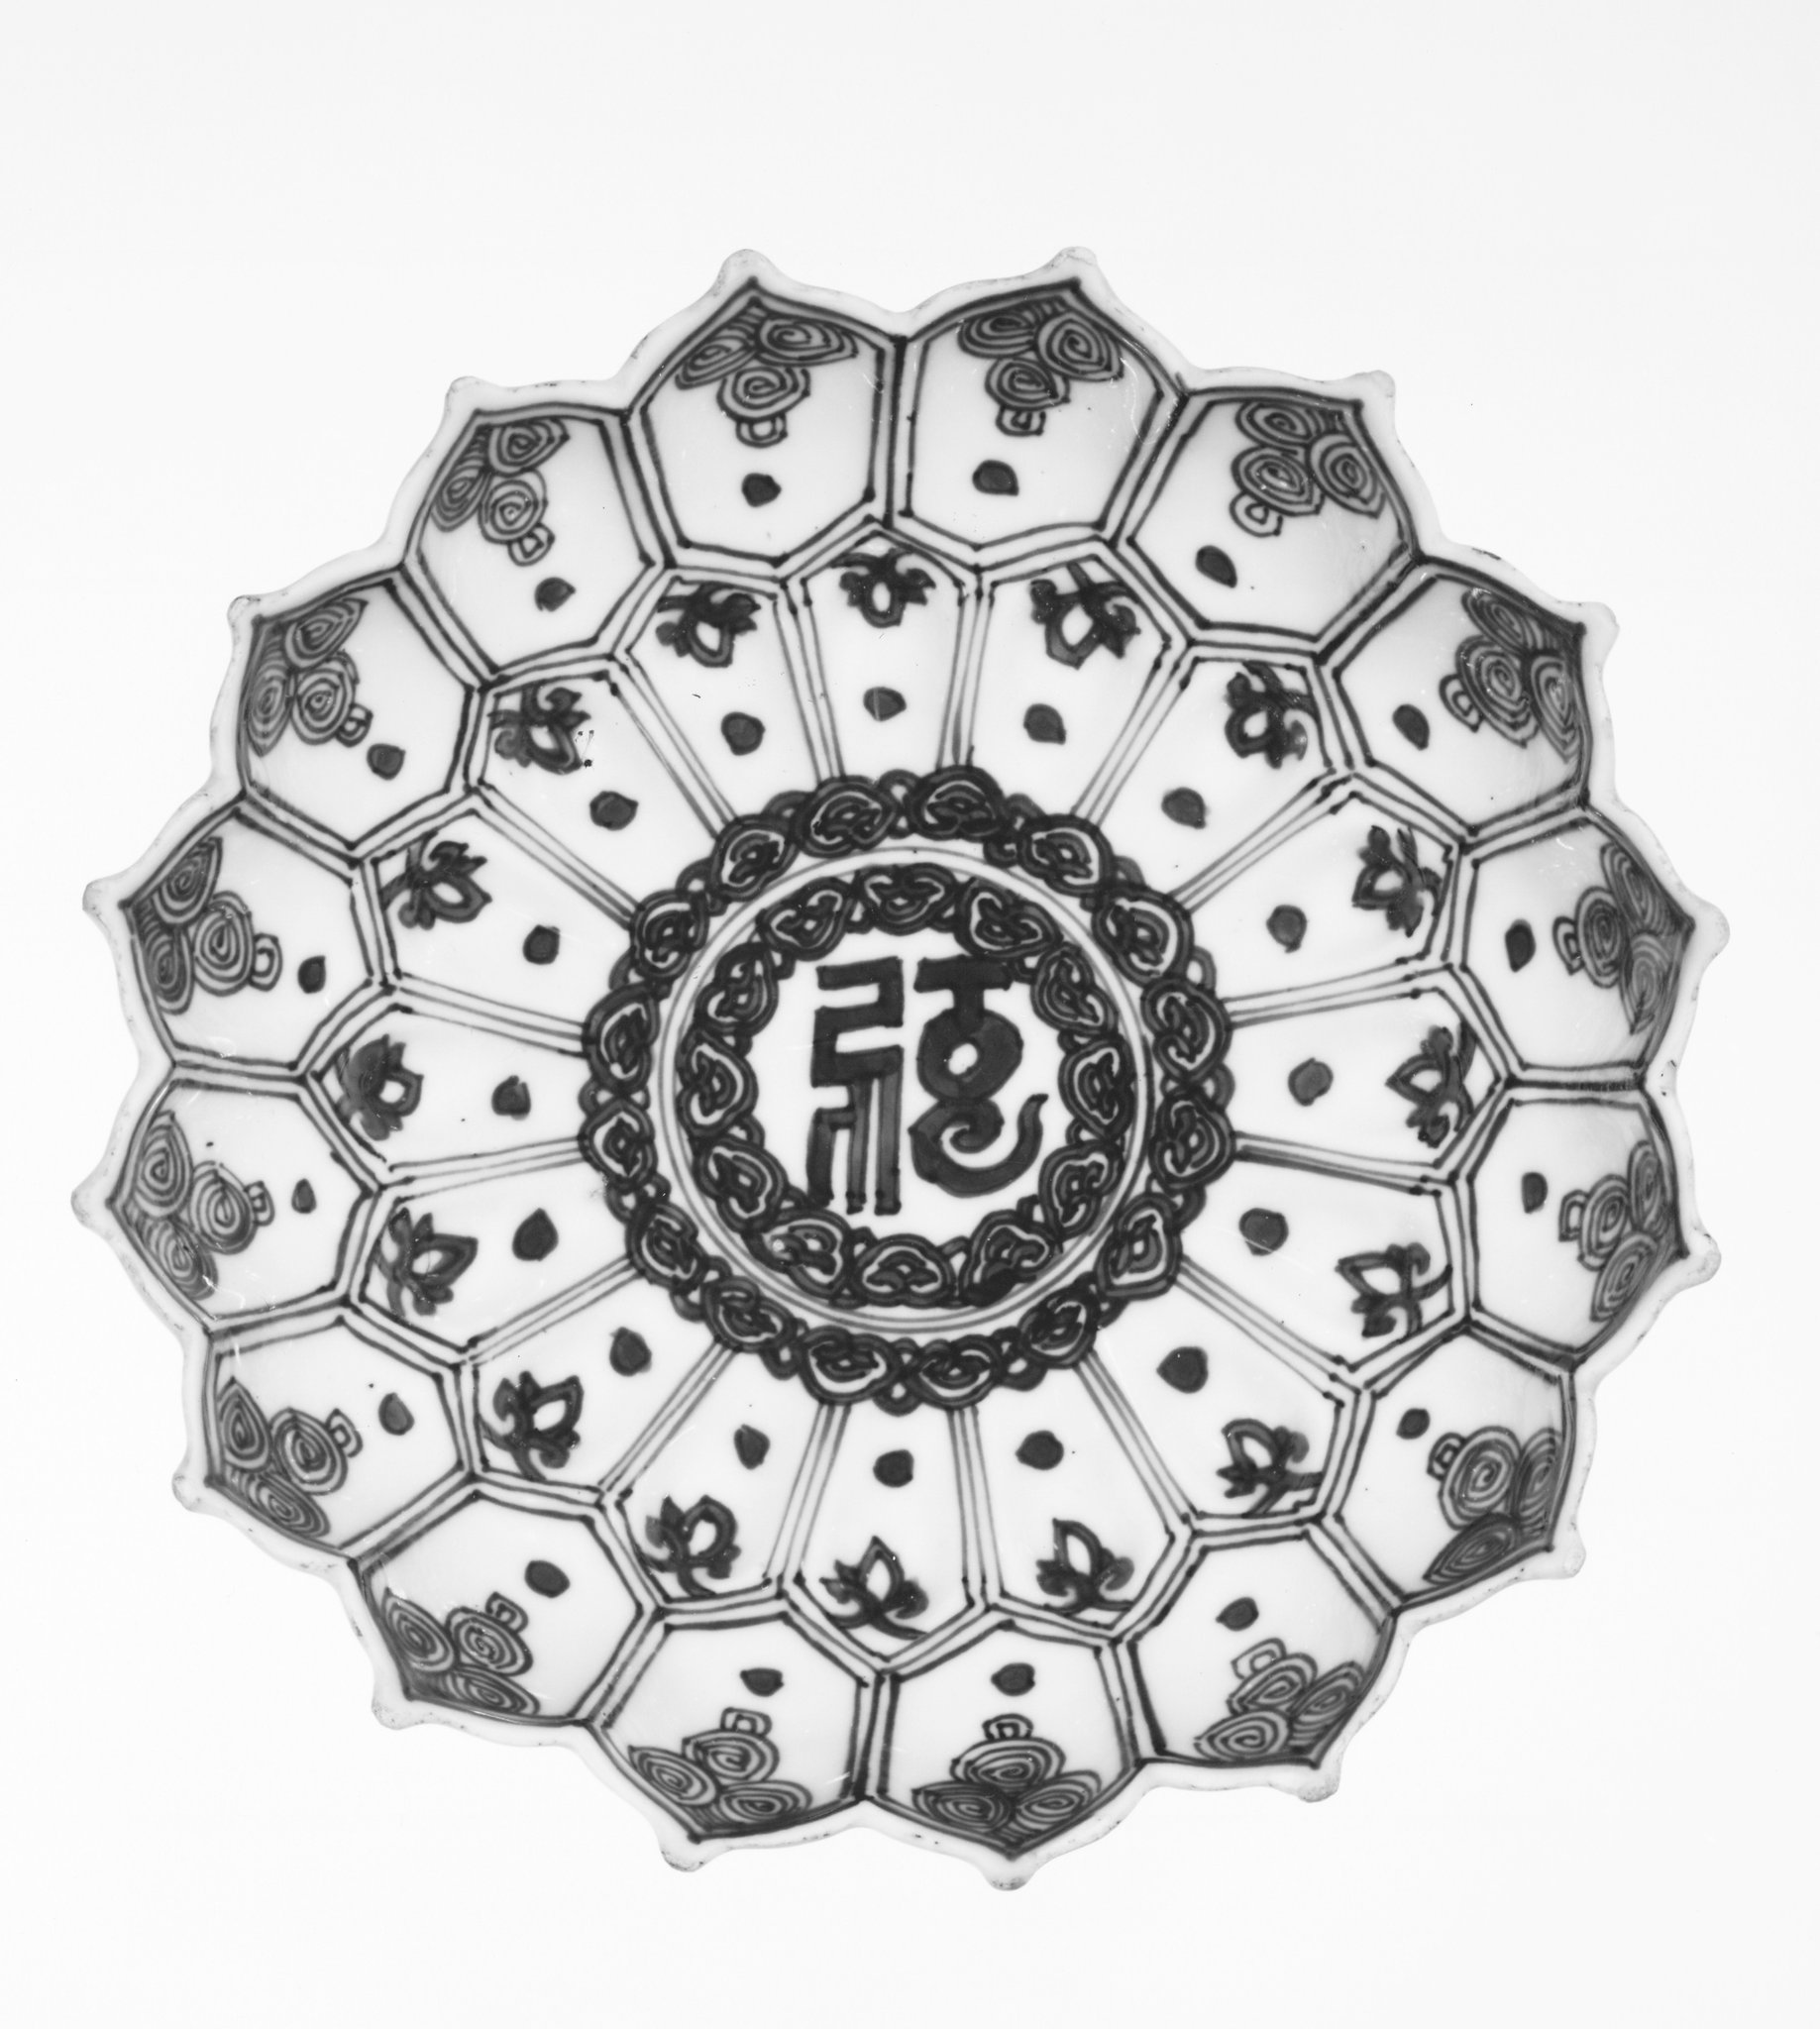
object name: bowl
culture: chinese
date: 1573-1620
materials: porcelain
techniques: painting, underglaze